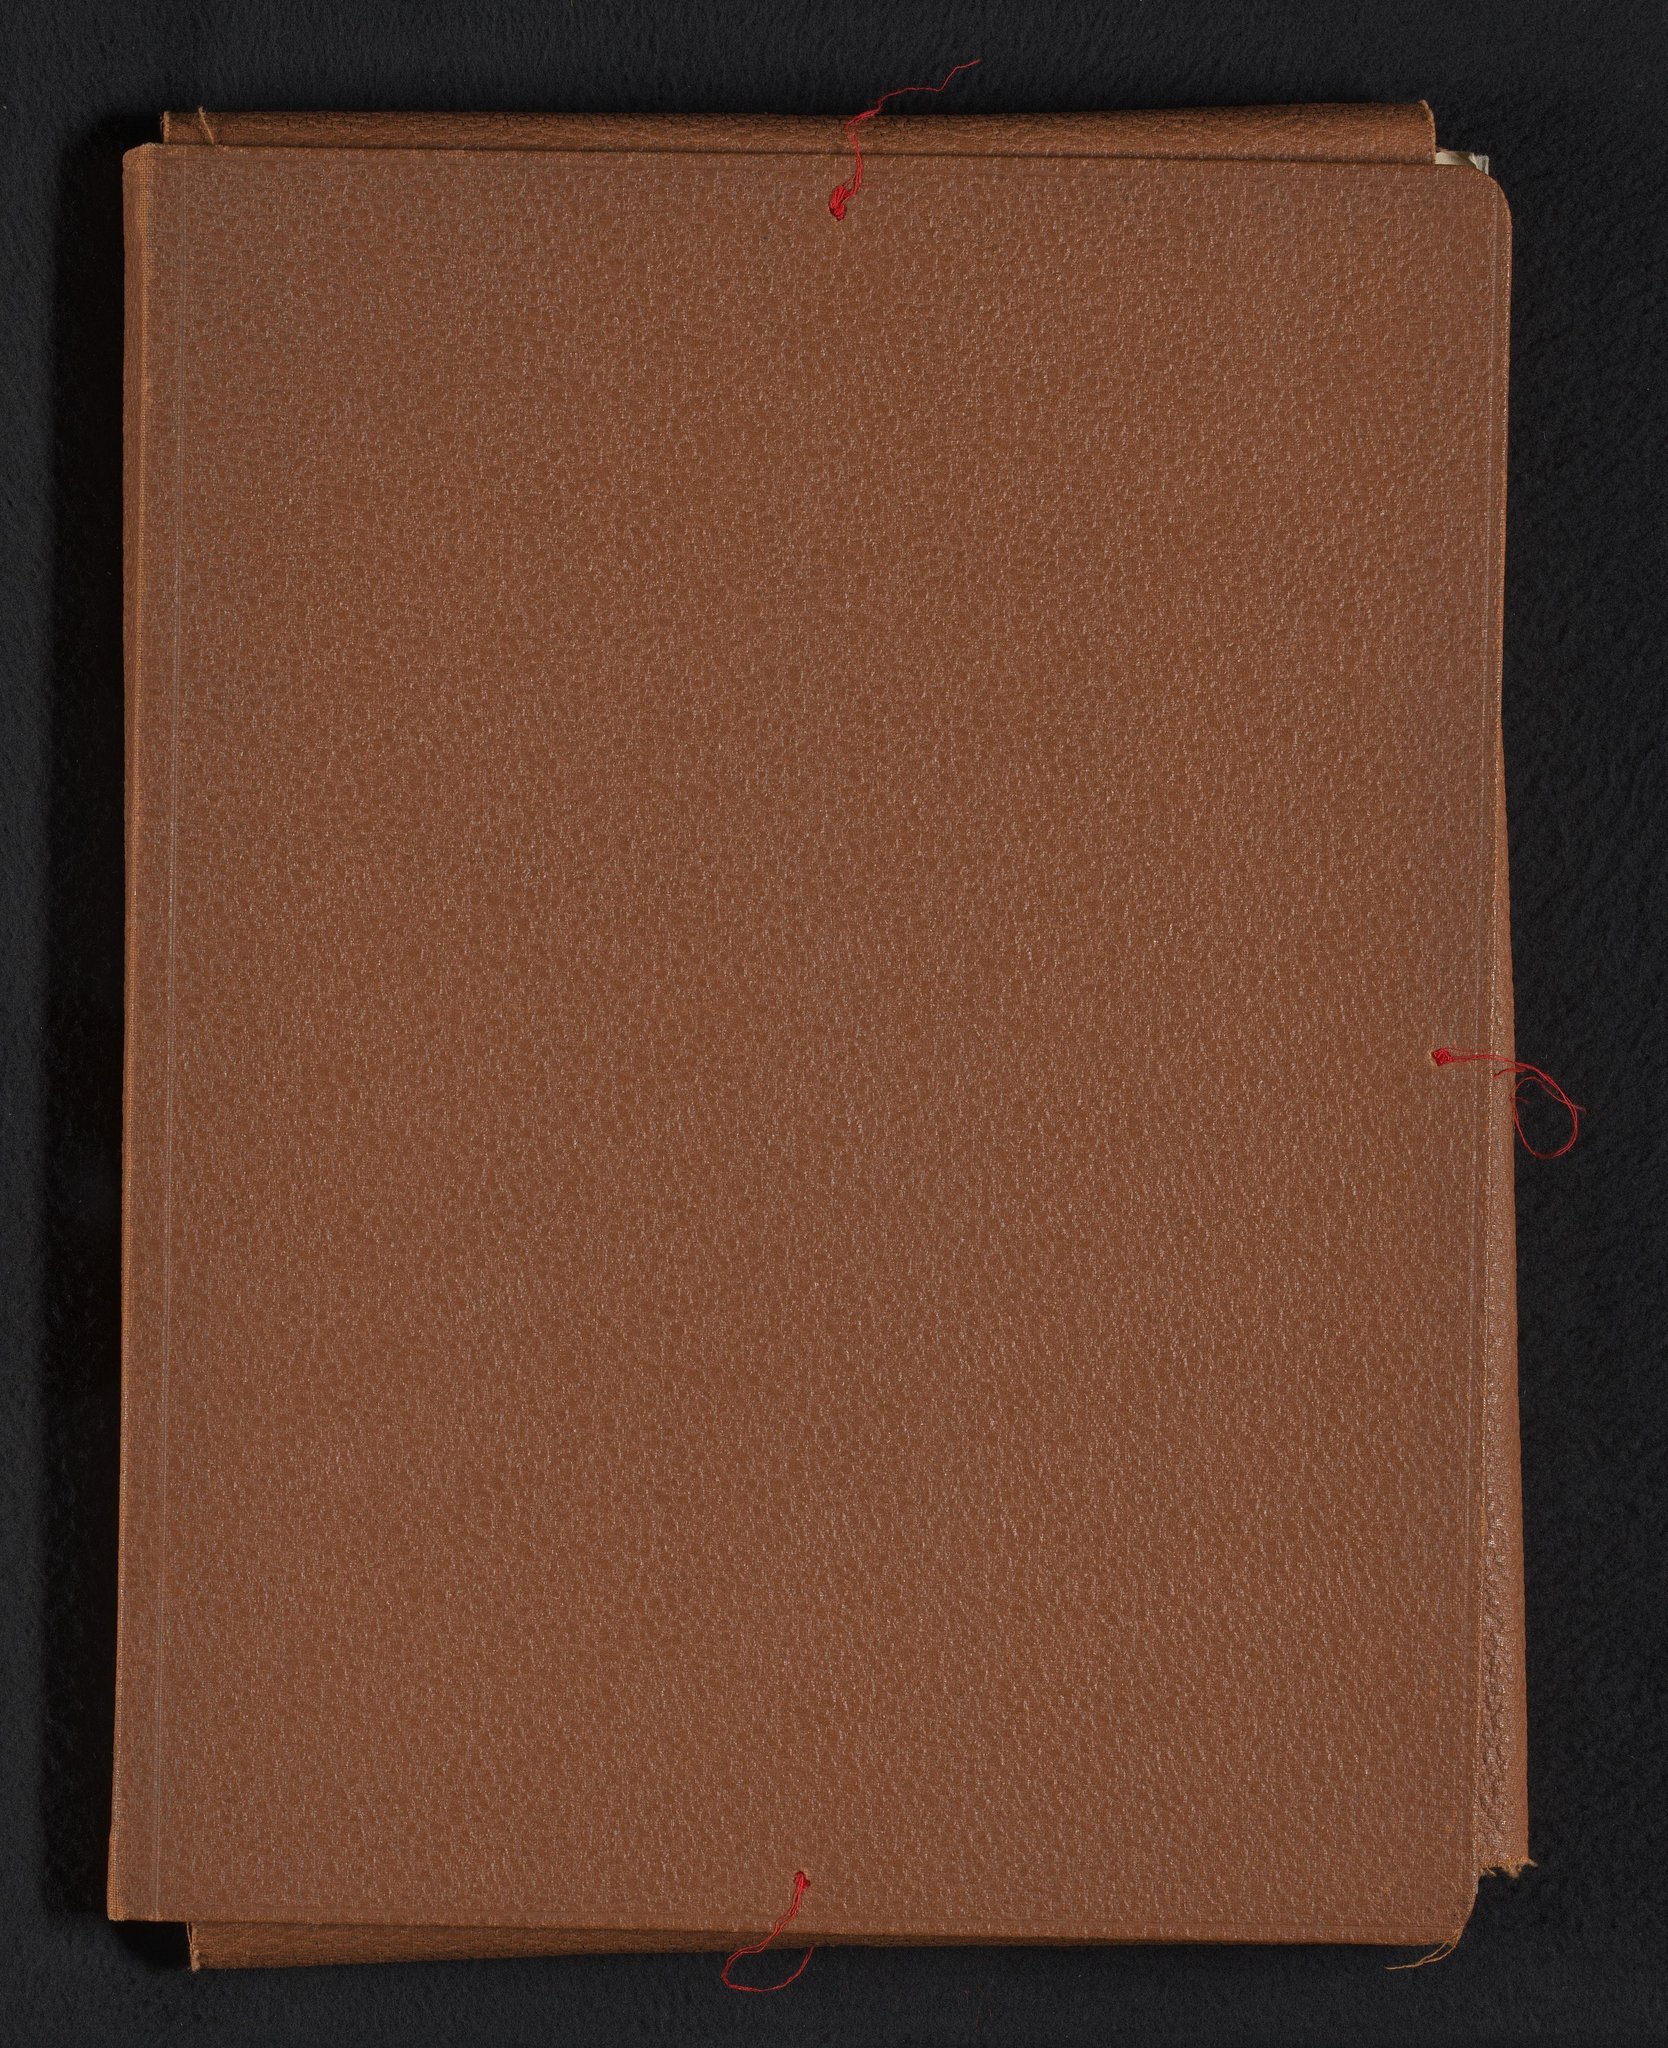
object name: photograph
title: Omslag met negen losse foto's, negen gebundelde bladen met 10 foto's en een losse tekening van Johanna (Hans) Stokhuyzen-de Jong en haar omgeving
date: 1880-1938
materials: cardboard, linen, paper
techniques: decorated paper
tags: leiden, johanna petronella lambertina stokhuyzen-de jong (hans), adult man